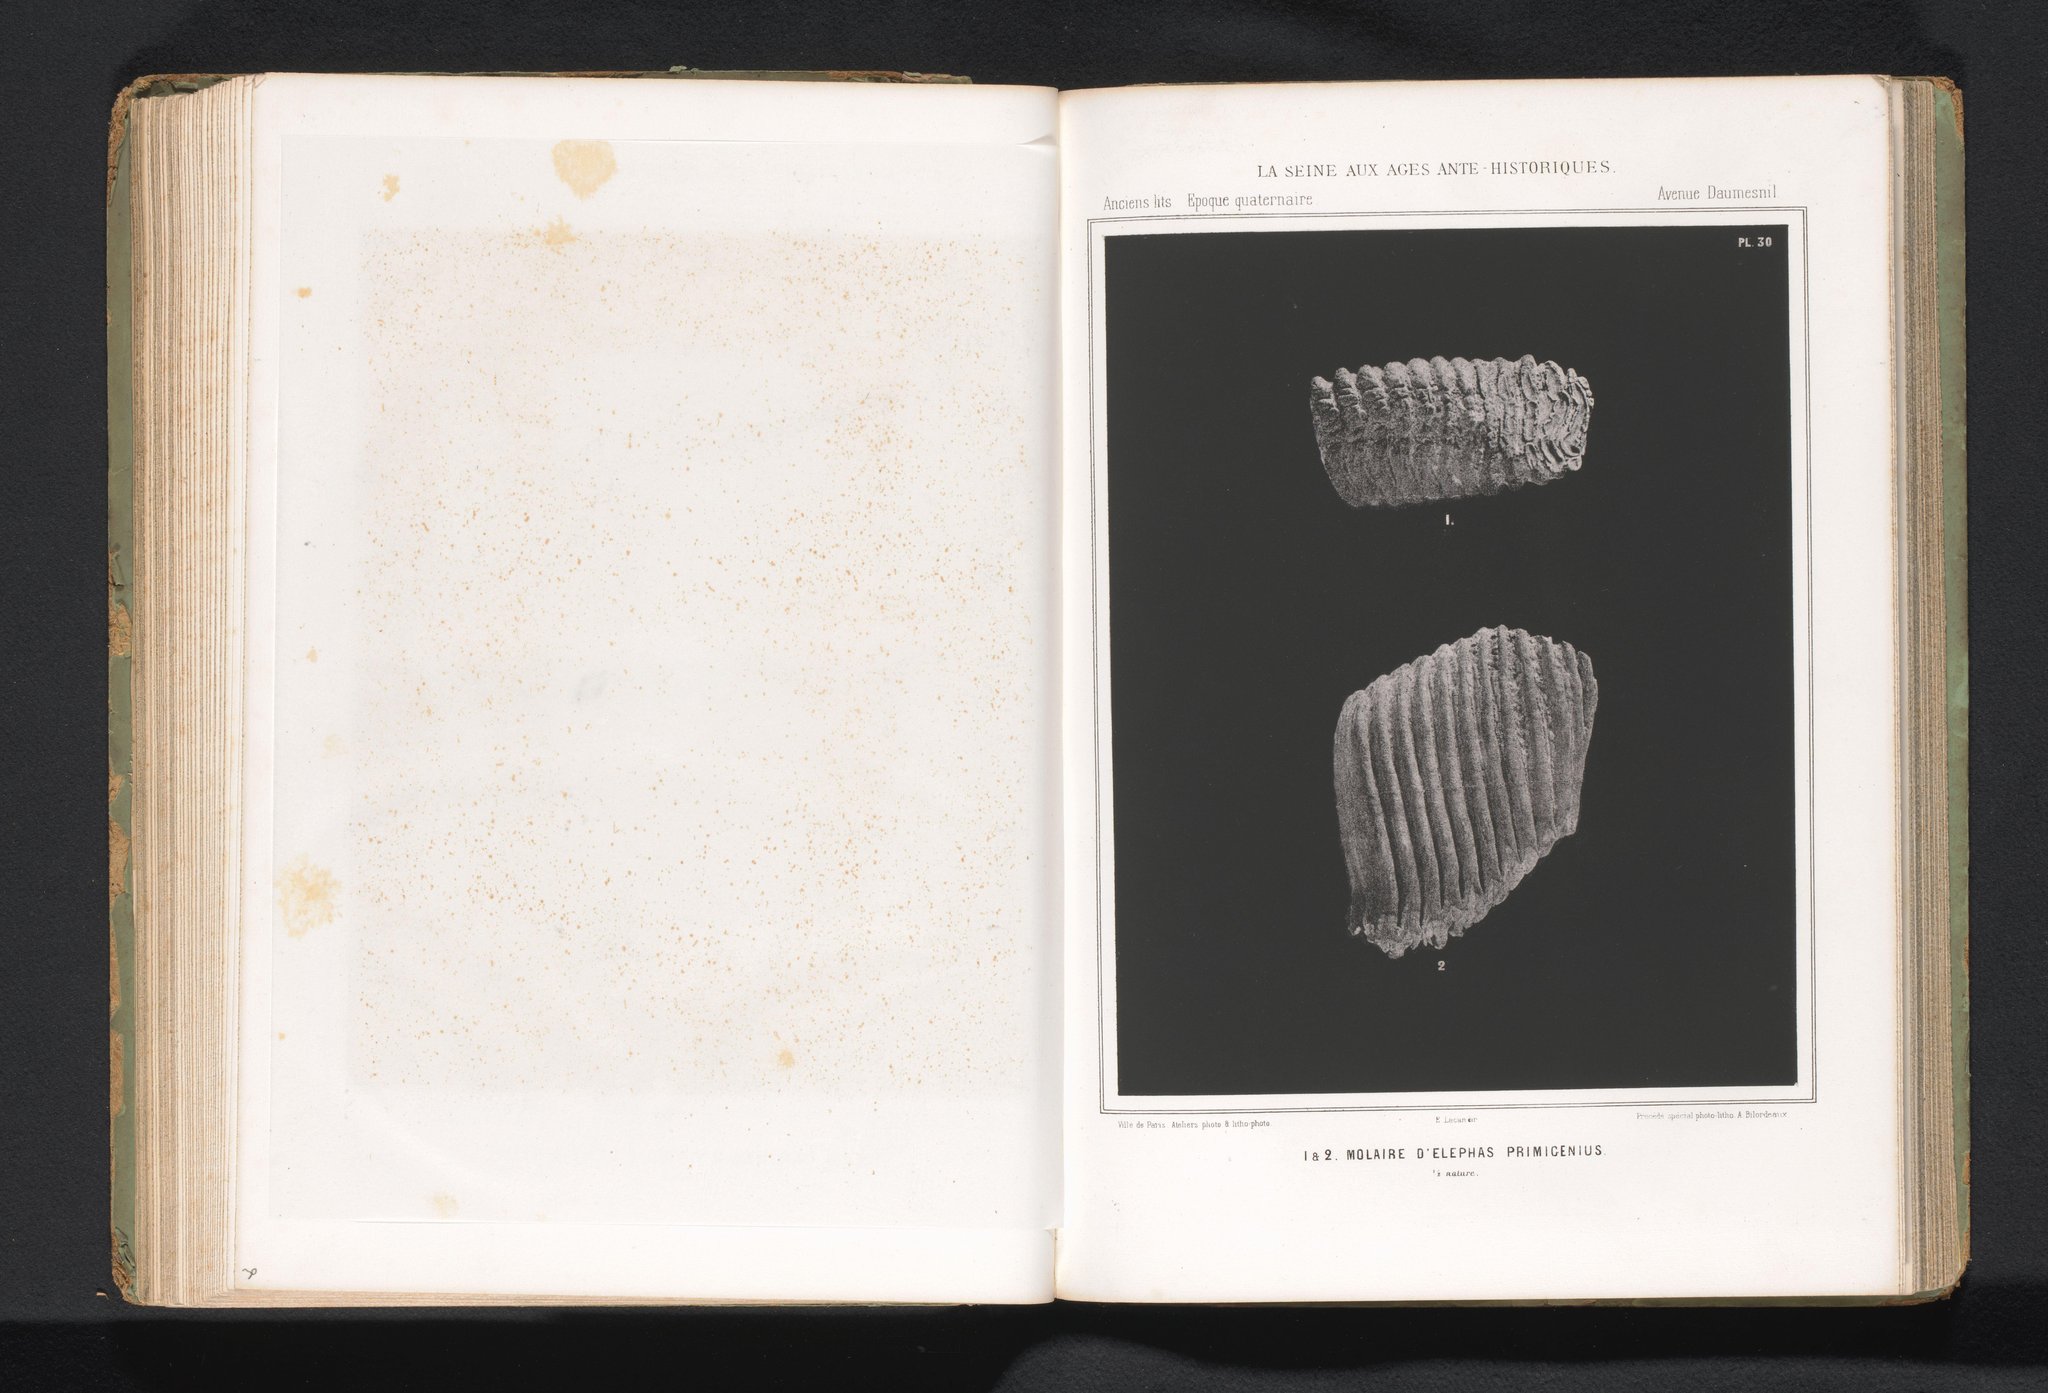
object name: page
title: Molaire d'Elephas primigenius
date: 1864-1869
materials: paper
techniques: photolithography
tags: mammals (+ skeleton of an animal), palaeontology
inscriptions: inscription: ‘1/2 nature’, inscription: ‘Procédé spécial photo-litho. A. Bilordeaux’, inscription: ‘PL. 30’